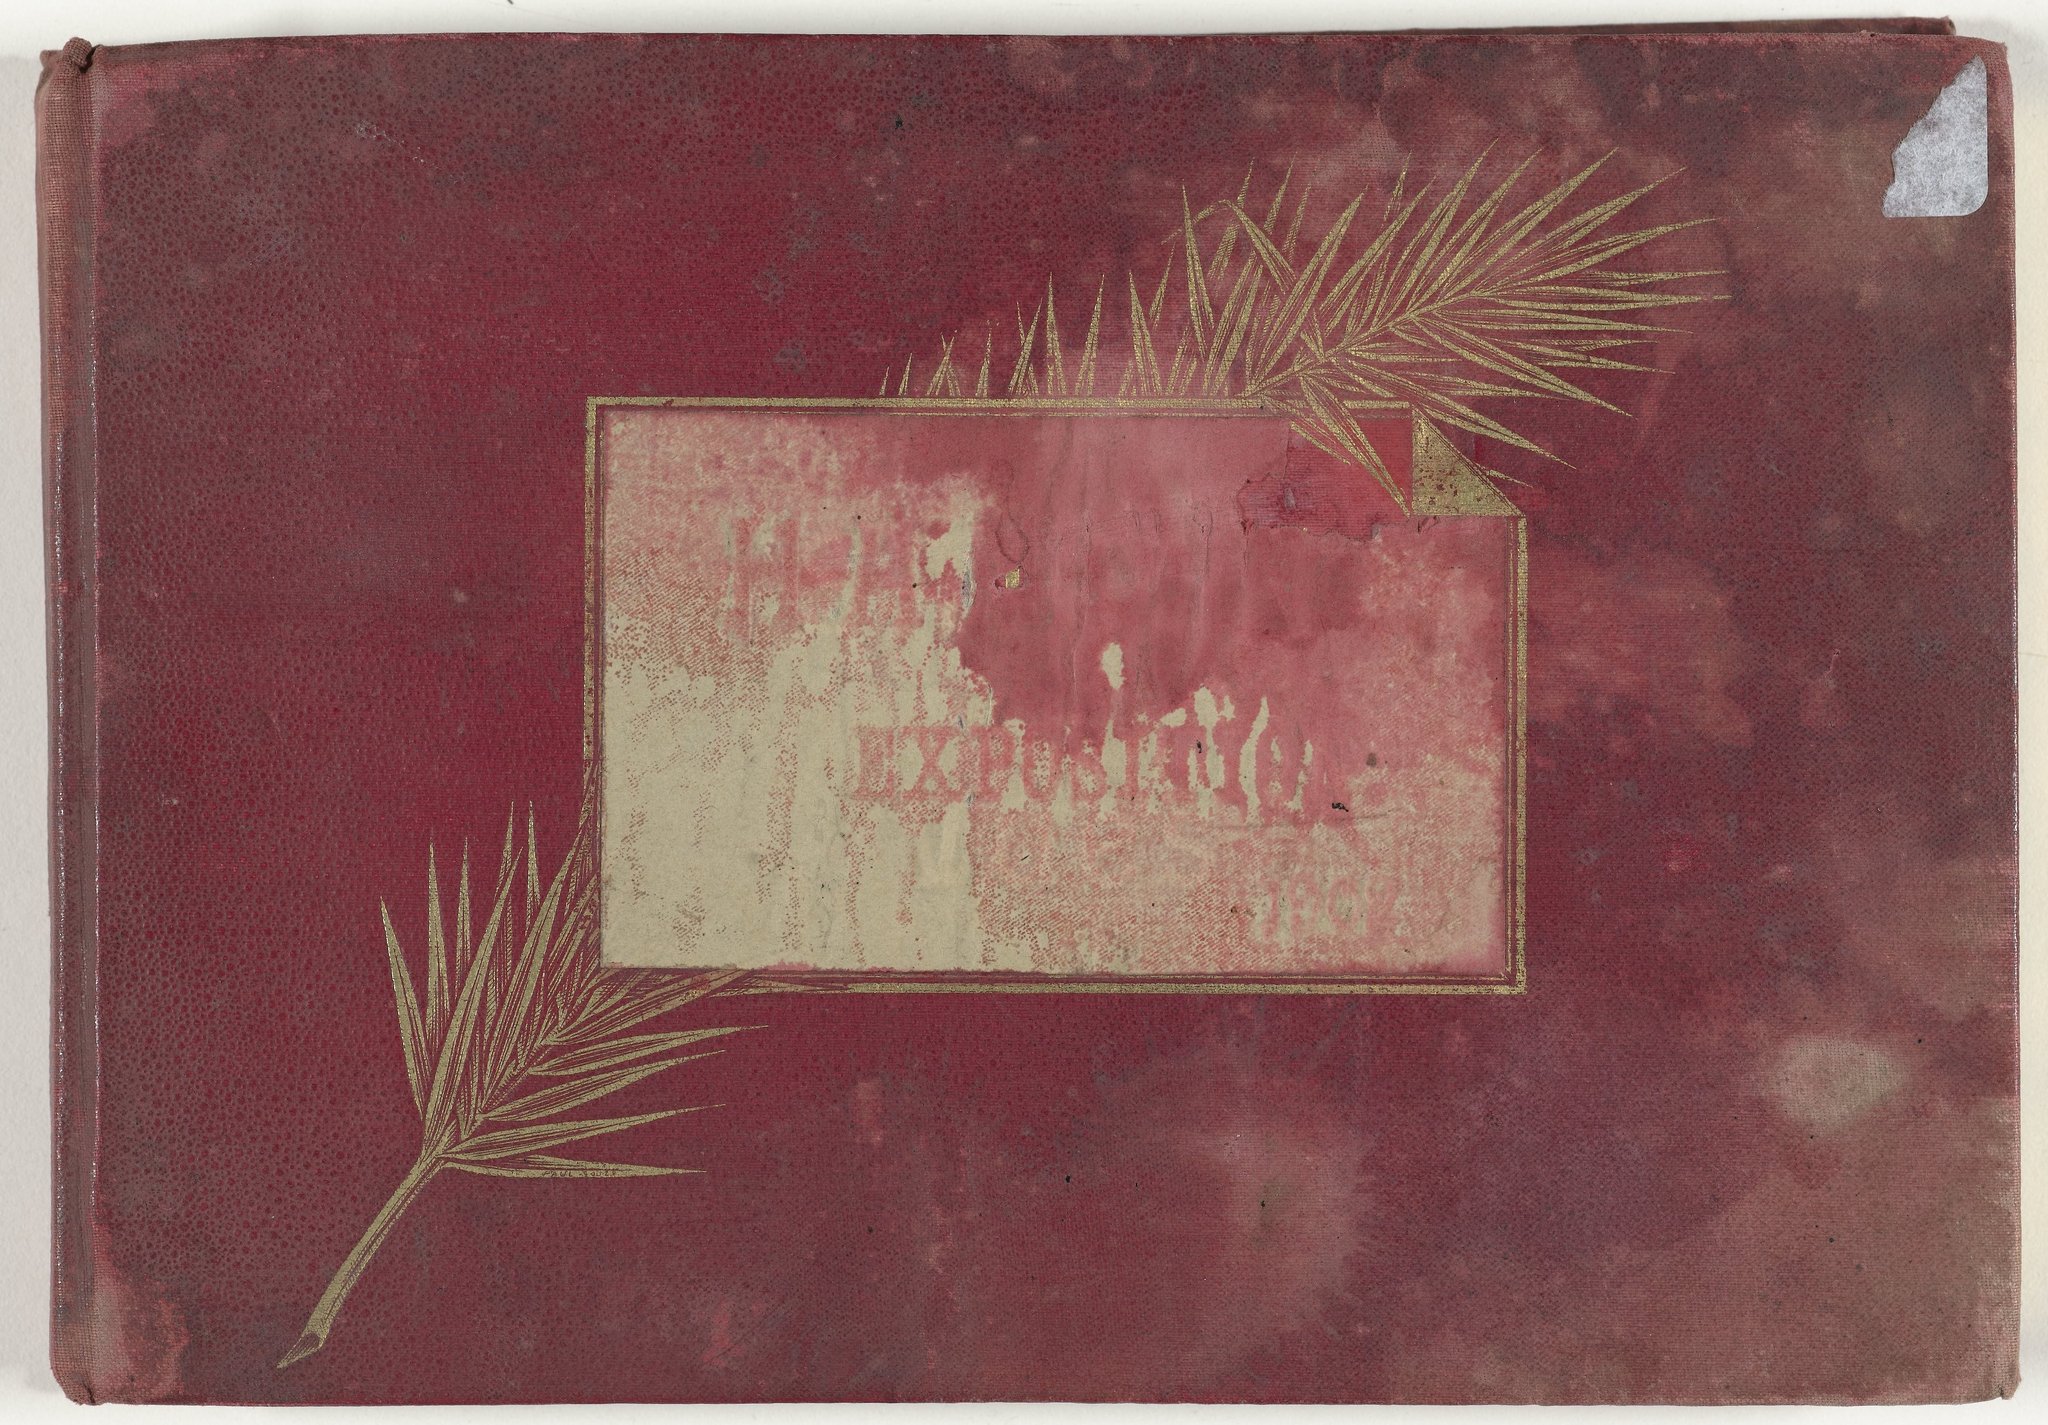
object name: scrapbook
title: Hanoi Exposition 1902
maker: Anonymous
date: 1902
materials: paper, cardboard, linen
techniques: gelatin silver print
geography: vietnam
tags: colonial system, island, world fair, world exhibition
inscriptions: inscription: ‘Hanoi/ Exposition/ 1902’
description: Plakboek met twaalf ontwikkelgelatinezilverdrukken van het toenmalige Tonkin, een Frans protectoraat in het noorden van het huidige Vietnam. Het album is gemaakt ter gelegenheid van de Hanoi Exposition, een onofficiële wereldtentoonstelling in Hanoi in 1902-1903. In tegenstelling tot wat de titel suggereert, bevat het album geen foto's van de tentoonstelling. In plaats daarvan ziet men landschappen, steden en dorpen en de inwoners van Tonkin. Het album bevat geen bijschriften - op de laatste foto na - en de fotograaf is ook niet bekend. Waarschijnlijk zijn de foto's gemaakt door een professionele fotograaf en werd het album verkocht aan bezoekers en reizigers.